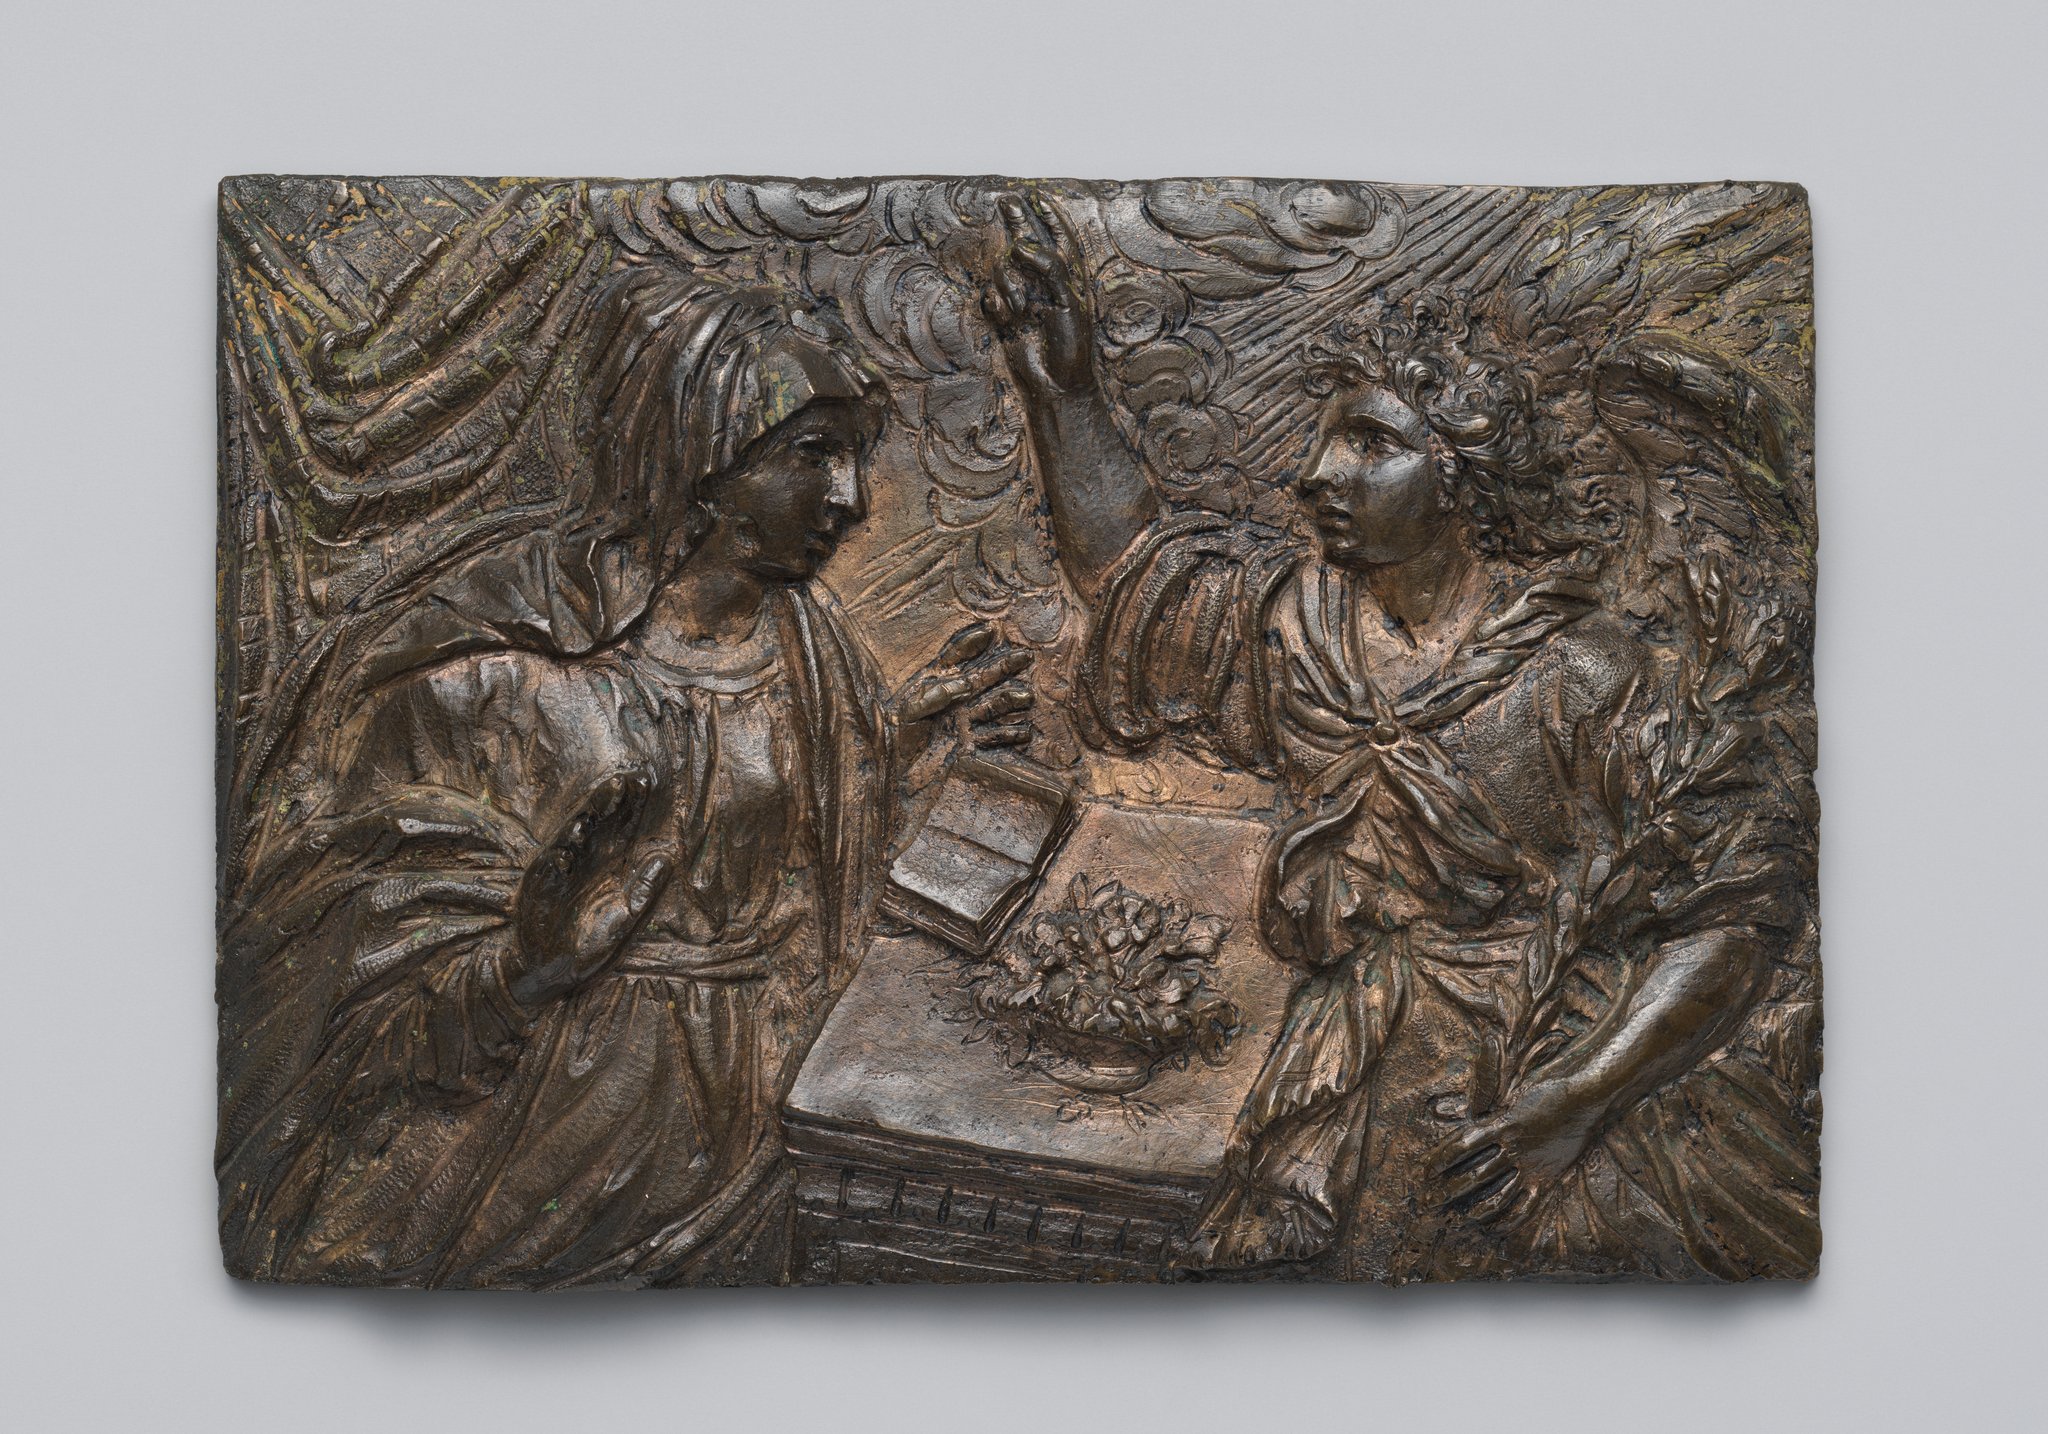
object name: relief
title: Annunciation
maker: niccolò roccatagliata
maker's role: artist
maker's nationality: italian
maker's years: 1593-1636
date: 1601-1633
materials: bronze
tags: women,angels,virgin mary,archangel gabriel,annunciation